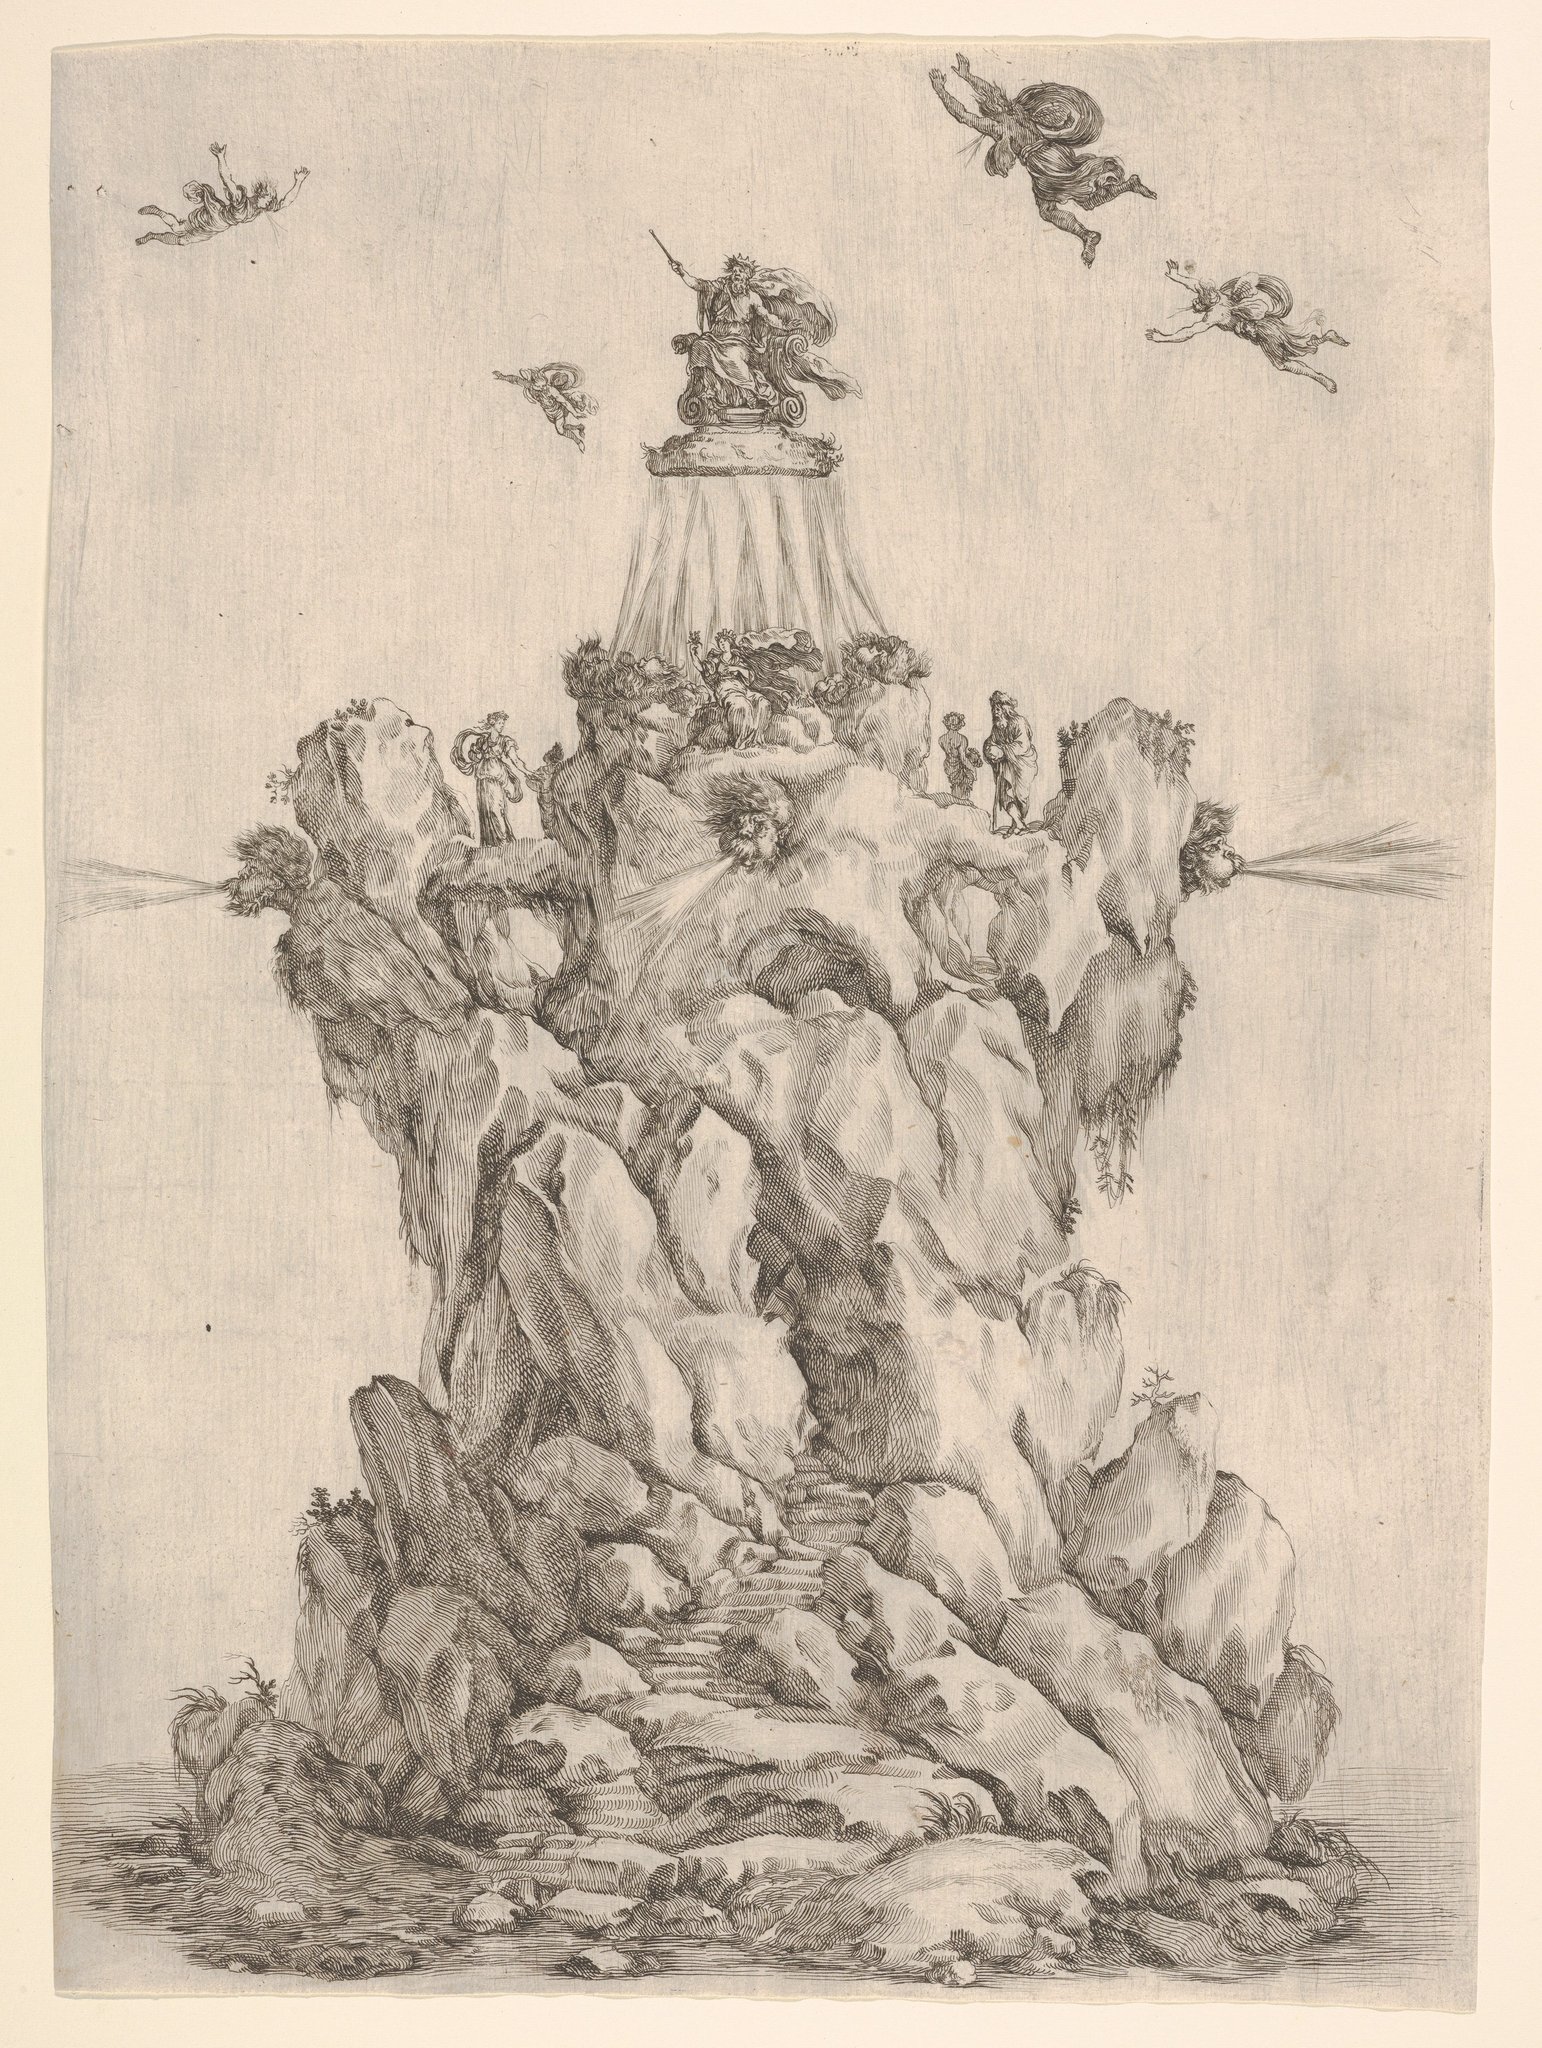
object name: print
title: The rock of Aeolus, surrounded by water, with steps leading up the rock, the heads of three of the four winds on each corner blowing outwards, Aeolus crowned at the summit, four winds in the sky around him, from "The contest of the seasons" (La gara delle stagioni)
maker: stefano della bella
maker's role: artist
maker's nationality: italian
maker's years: 1610-1664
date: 1652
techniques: etching